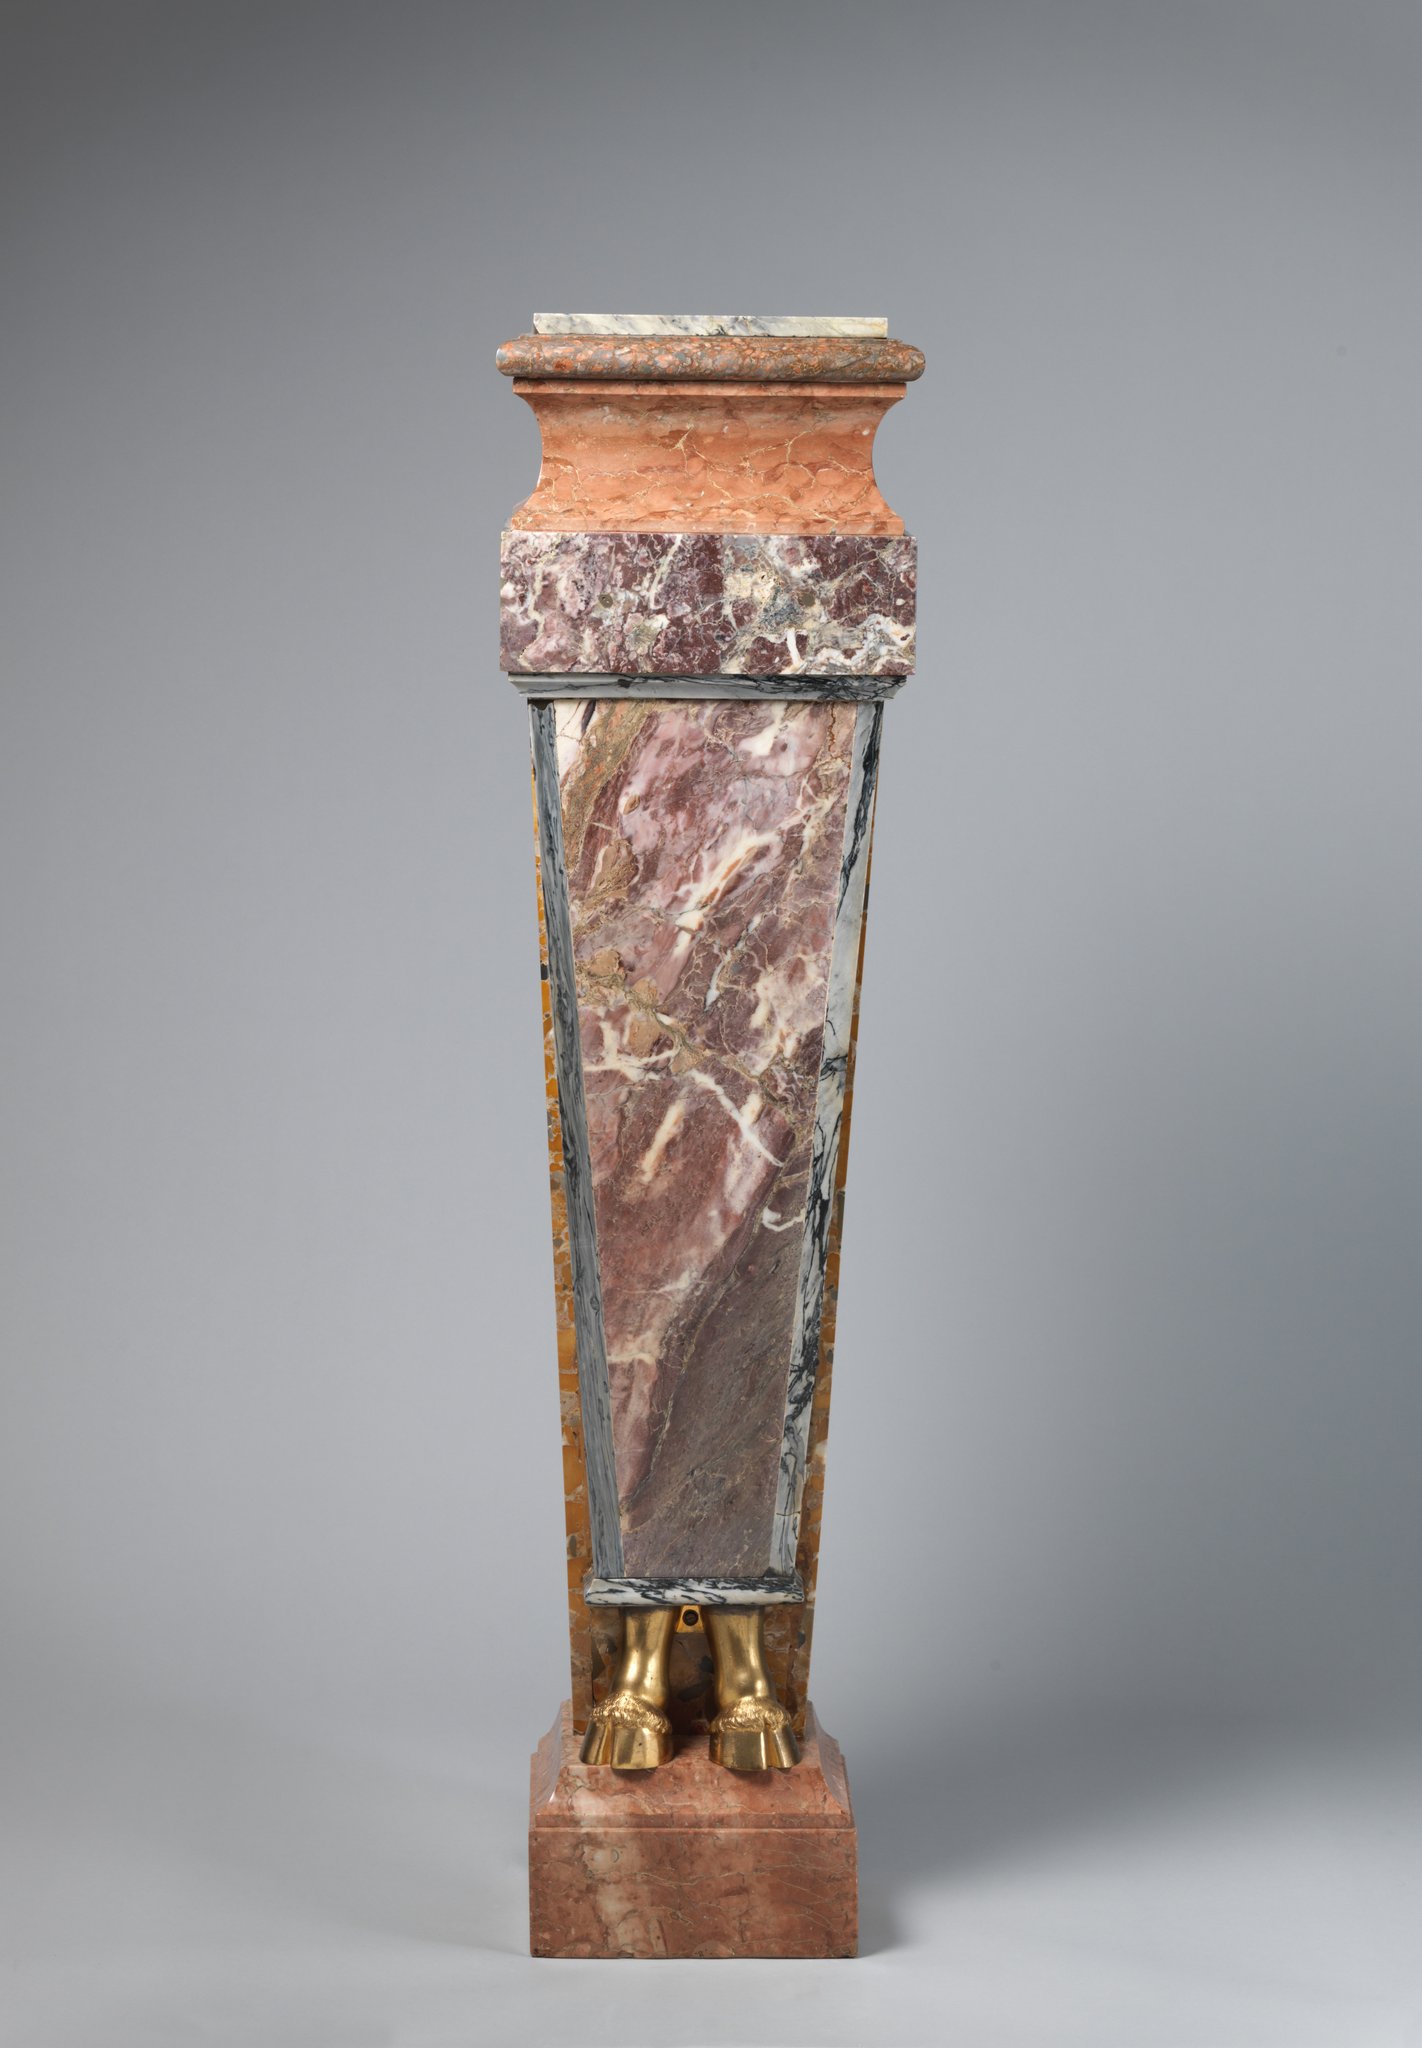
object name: pedestal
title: Pedestal with hooves (one of a pair)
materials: gilt, marble, metal